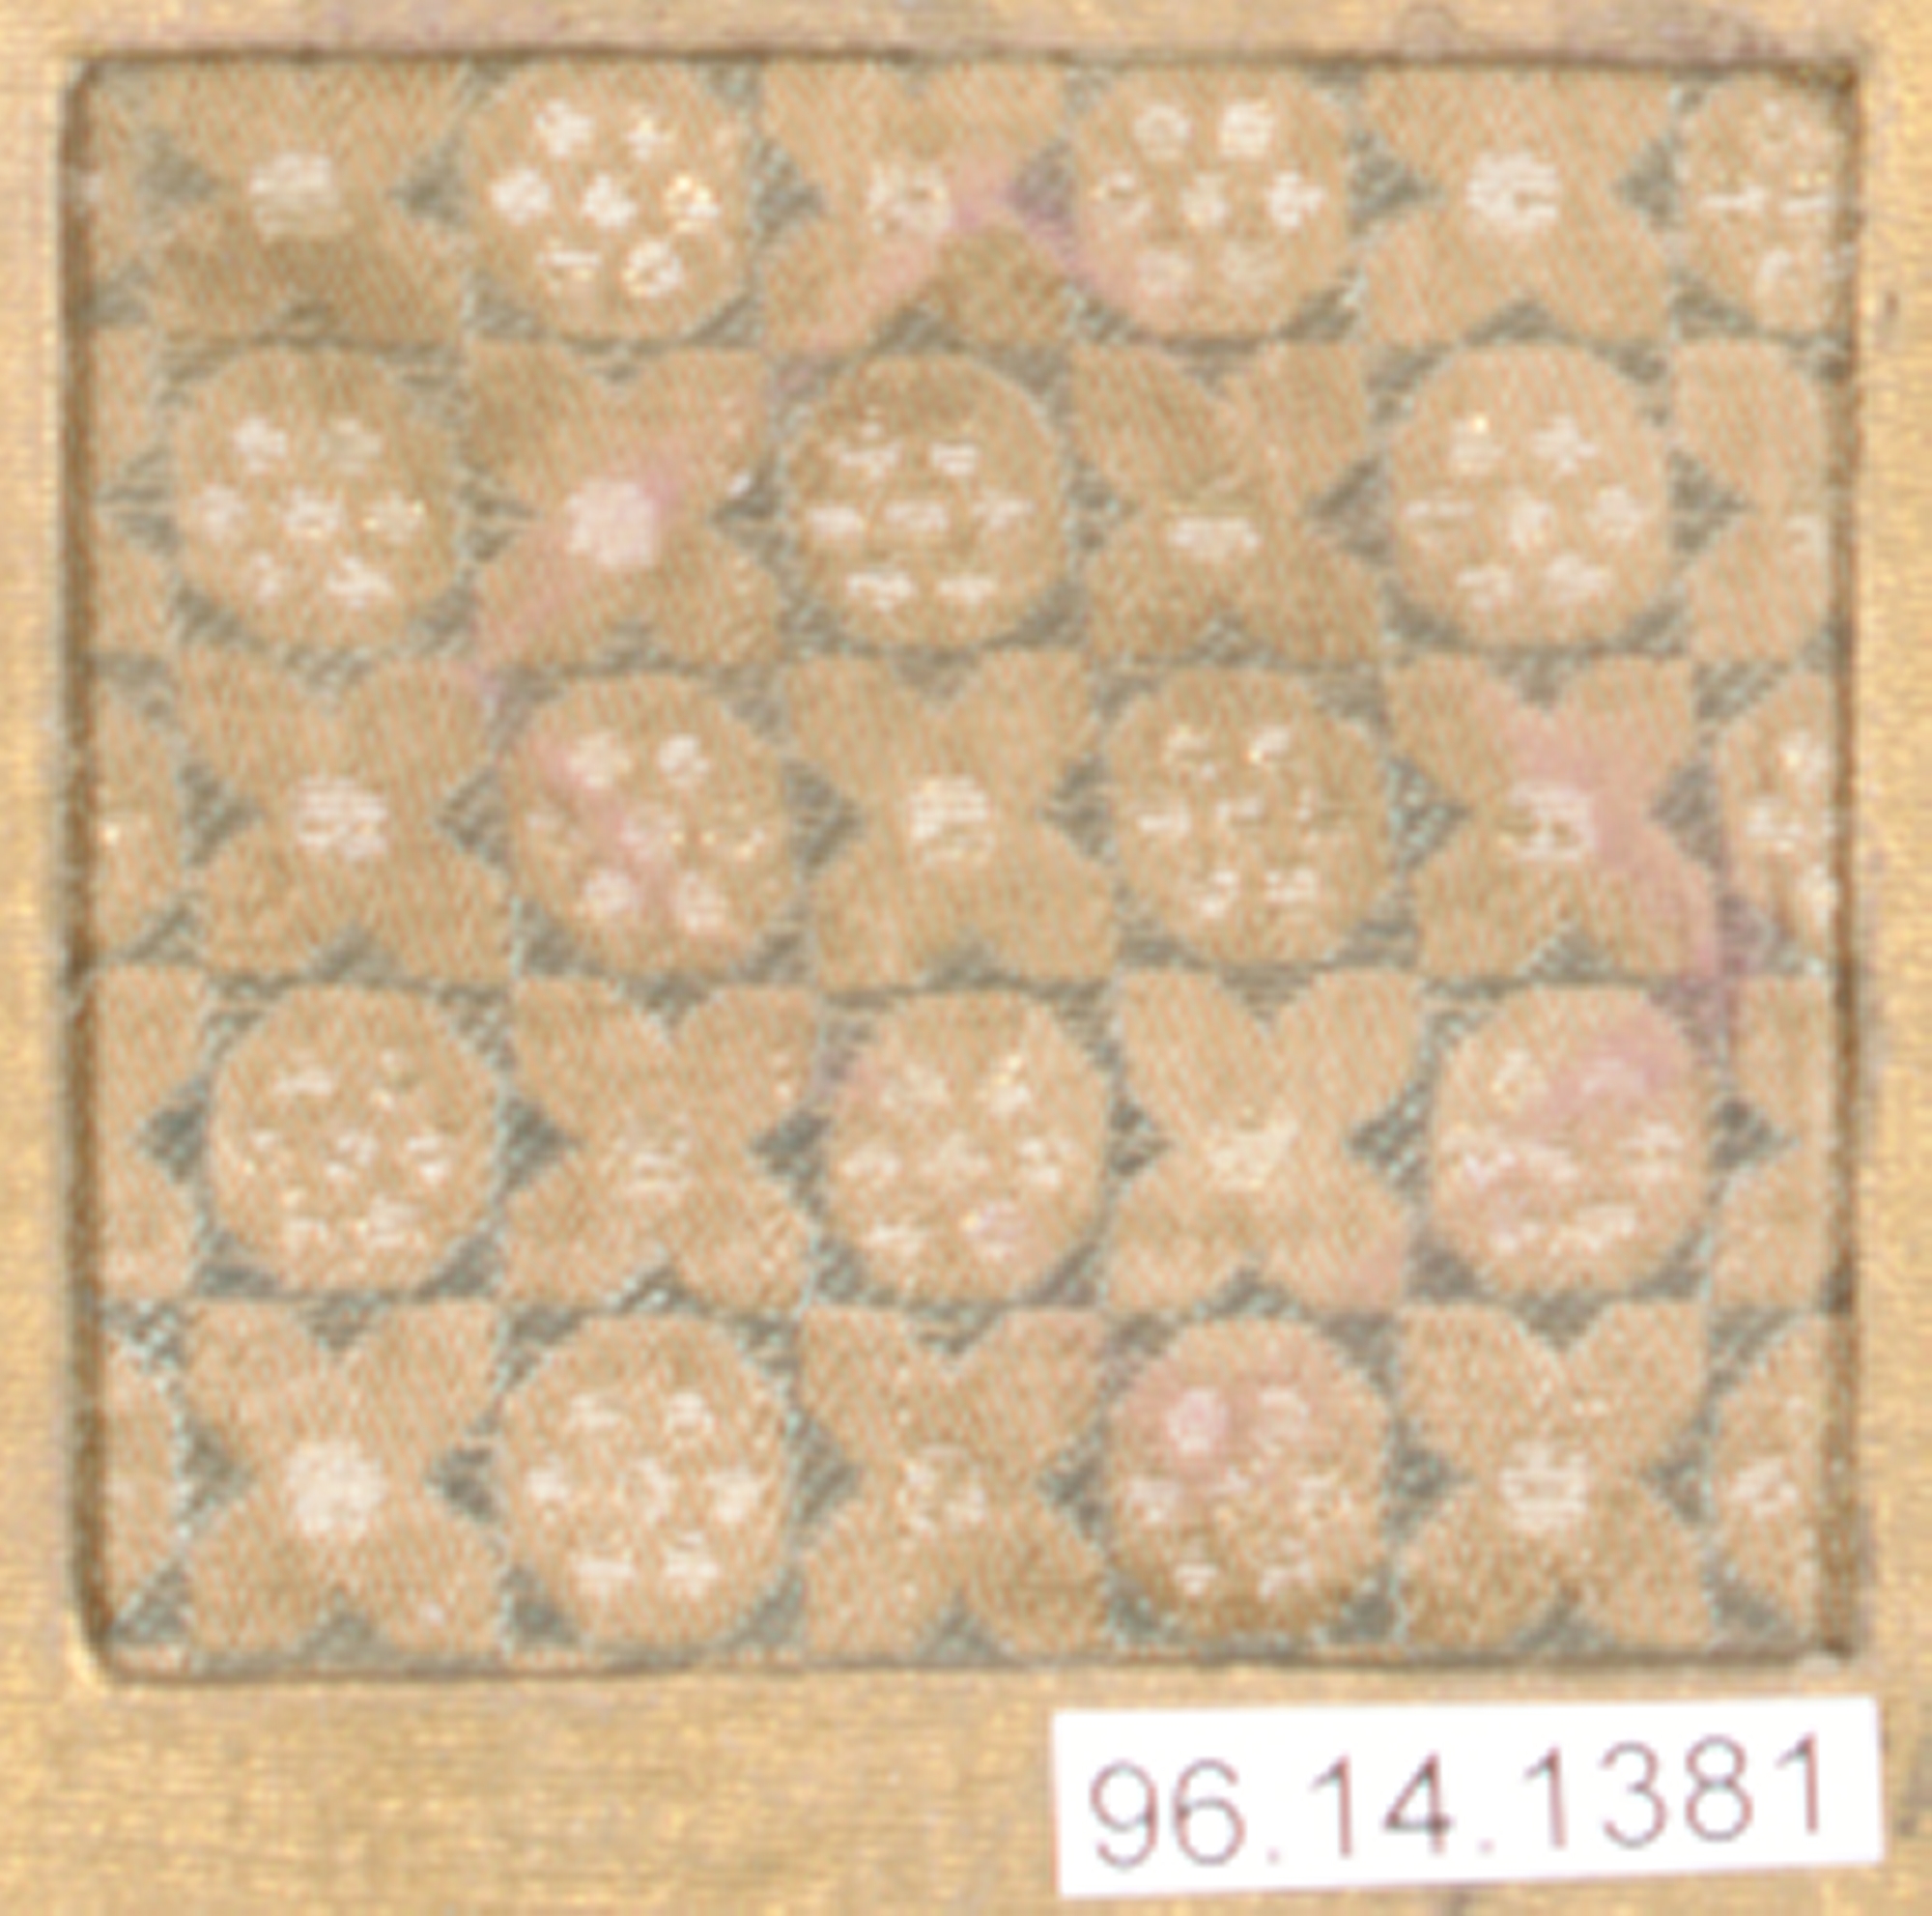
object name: piece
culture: japanese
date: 1701-1900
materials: silk